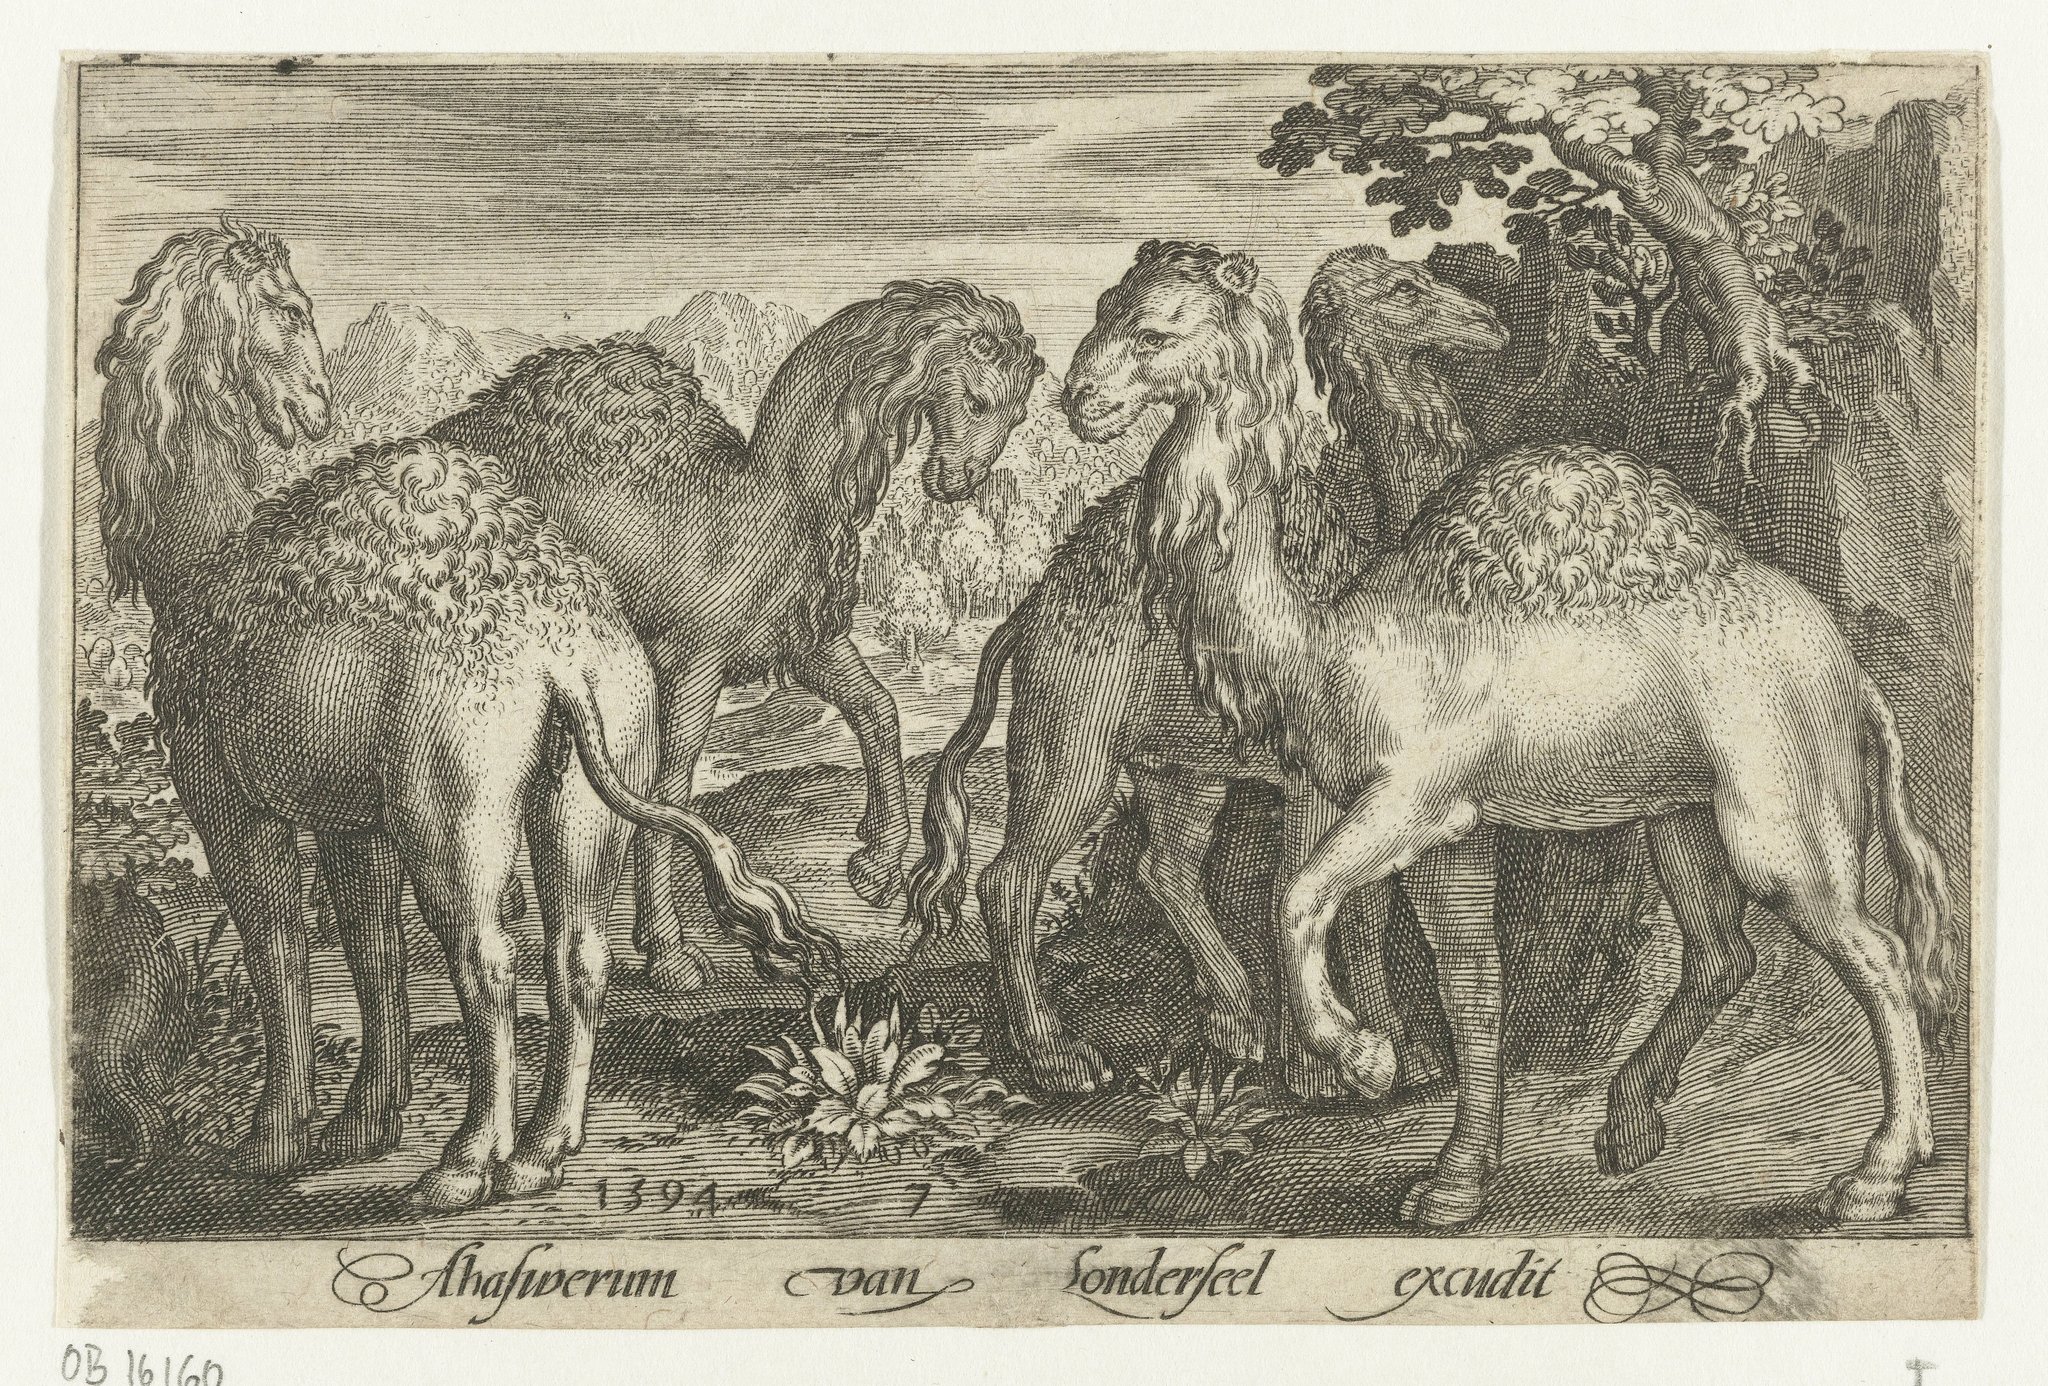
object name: print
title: Dieren in landschappen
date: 1594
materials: paper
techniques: engraving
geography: antwerp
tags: hoofed animals: dromedary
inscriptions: collector's mark: Lugt 2228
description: Prent uit serie Animalivm qvadrvpedvm van twaalf prenten met dieren (viervoeters) in landschappen. Hollstein beschrijft twee staten, als eerste staat een uitgave van Assuerus van Londerseel voor de nummering (gedateerd 1594) en als tweede staat een uitgave van Claes Jansz. Visscher (II) met nummering (gedateerd 1621). Er is echter nog een andere editie bekend van uitgever Christoffel van Sichem welke tussen deze twee staten in geplaatst kan worden. Verschillende drukken van Visscher vertonen nog sporen van een adres van Van Sichem, op een enkel blad in de collectie van het RMA staat zijn adres, vergelijk RP-P-OB-16.158. De editie van Visscher is gedrukt van zeer versleten platen, zie De Groot 1988, p. 36, 37.